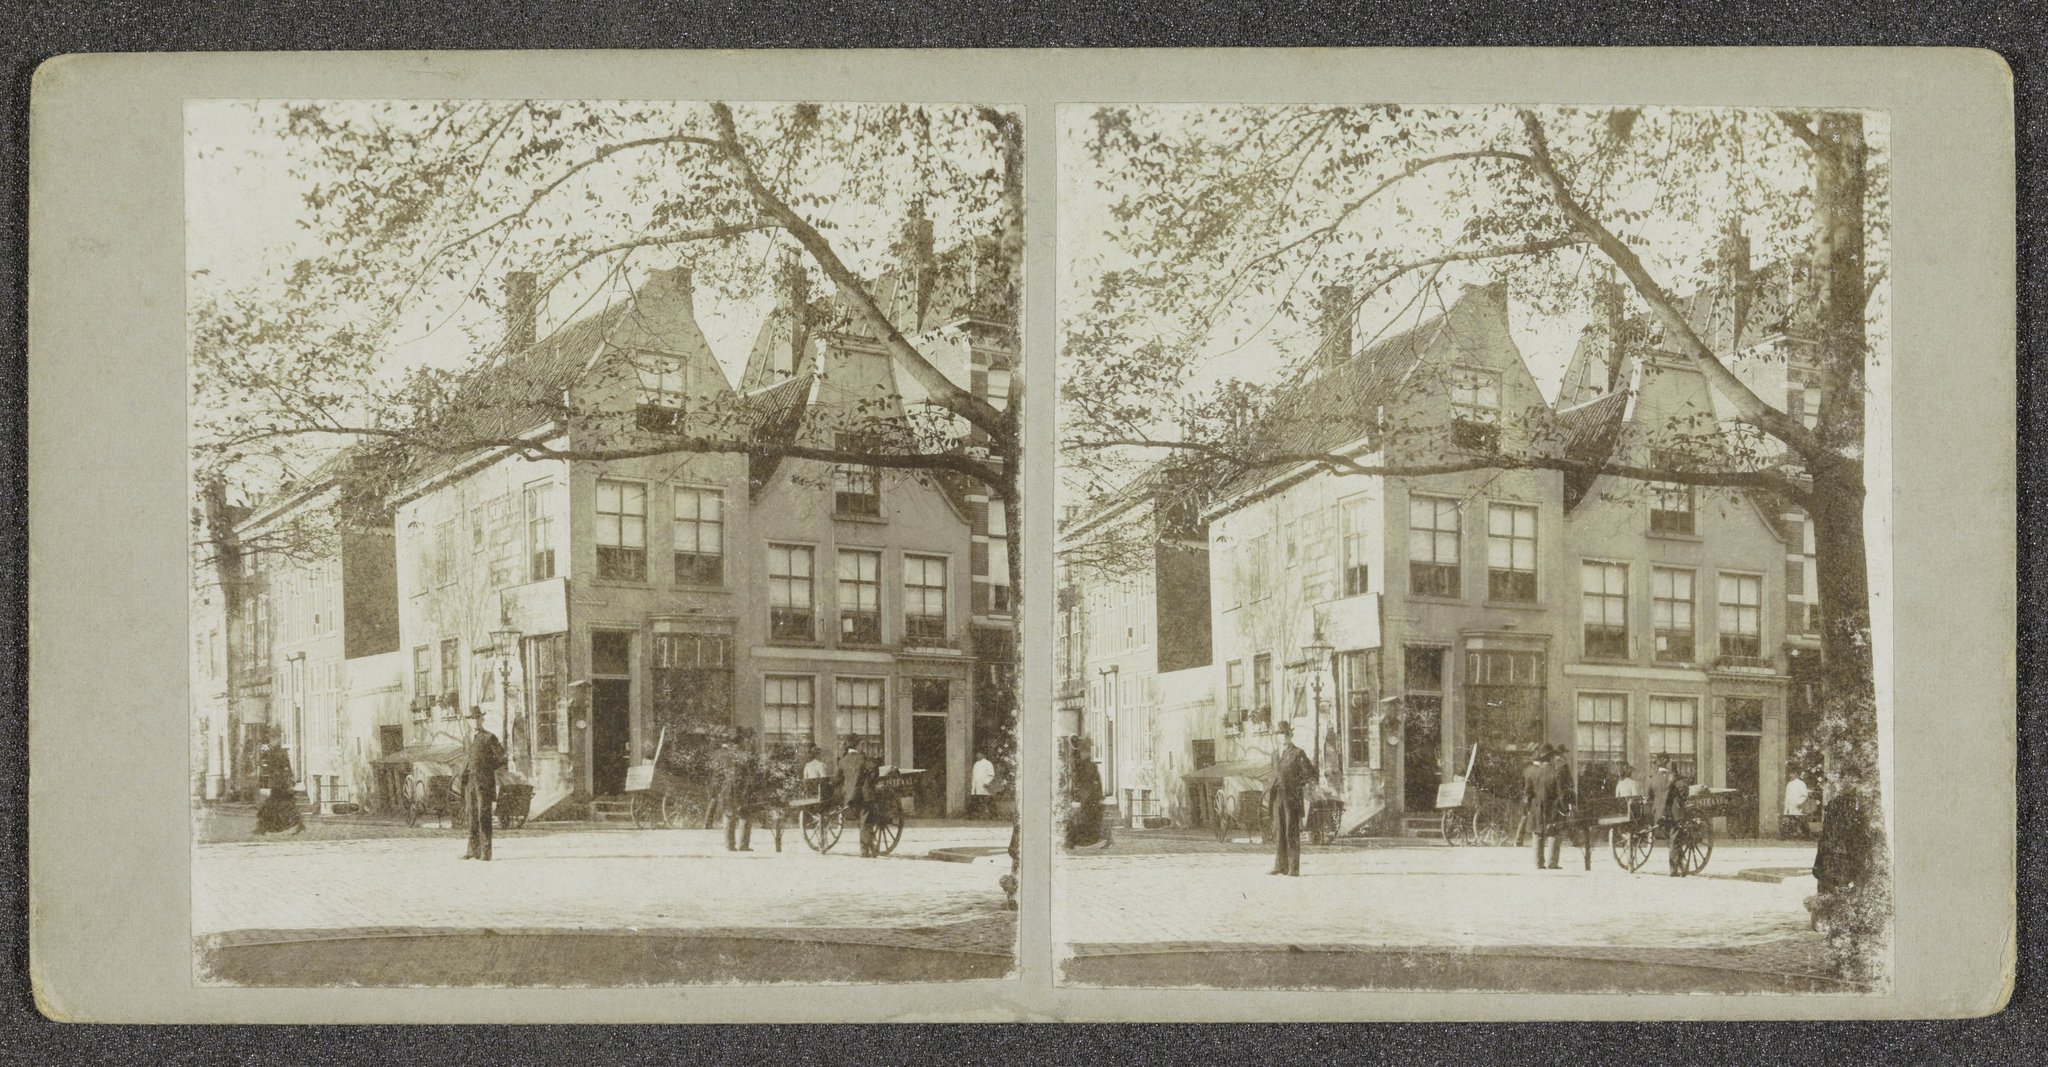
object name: stereograph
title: Haag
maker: wilhelm frederick antonius delboy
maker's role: fotograaf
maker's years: 1853-1928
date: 1884-1928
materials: cardboard, photographic support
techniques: collodion silver print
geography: the hague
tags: urban housing, street, the hague